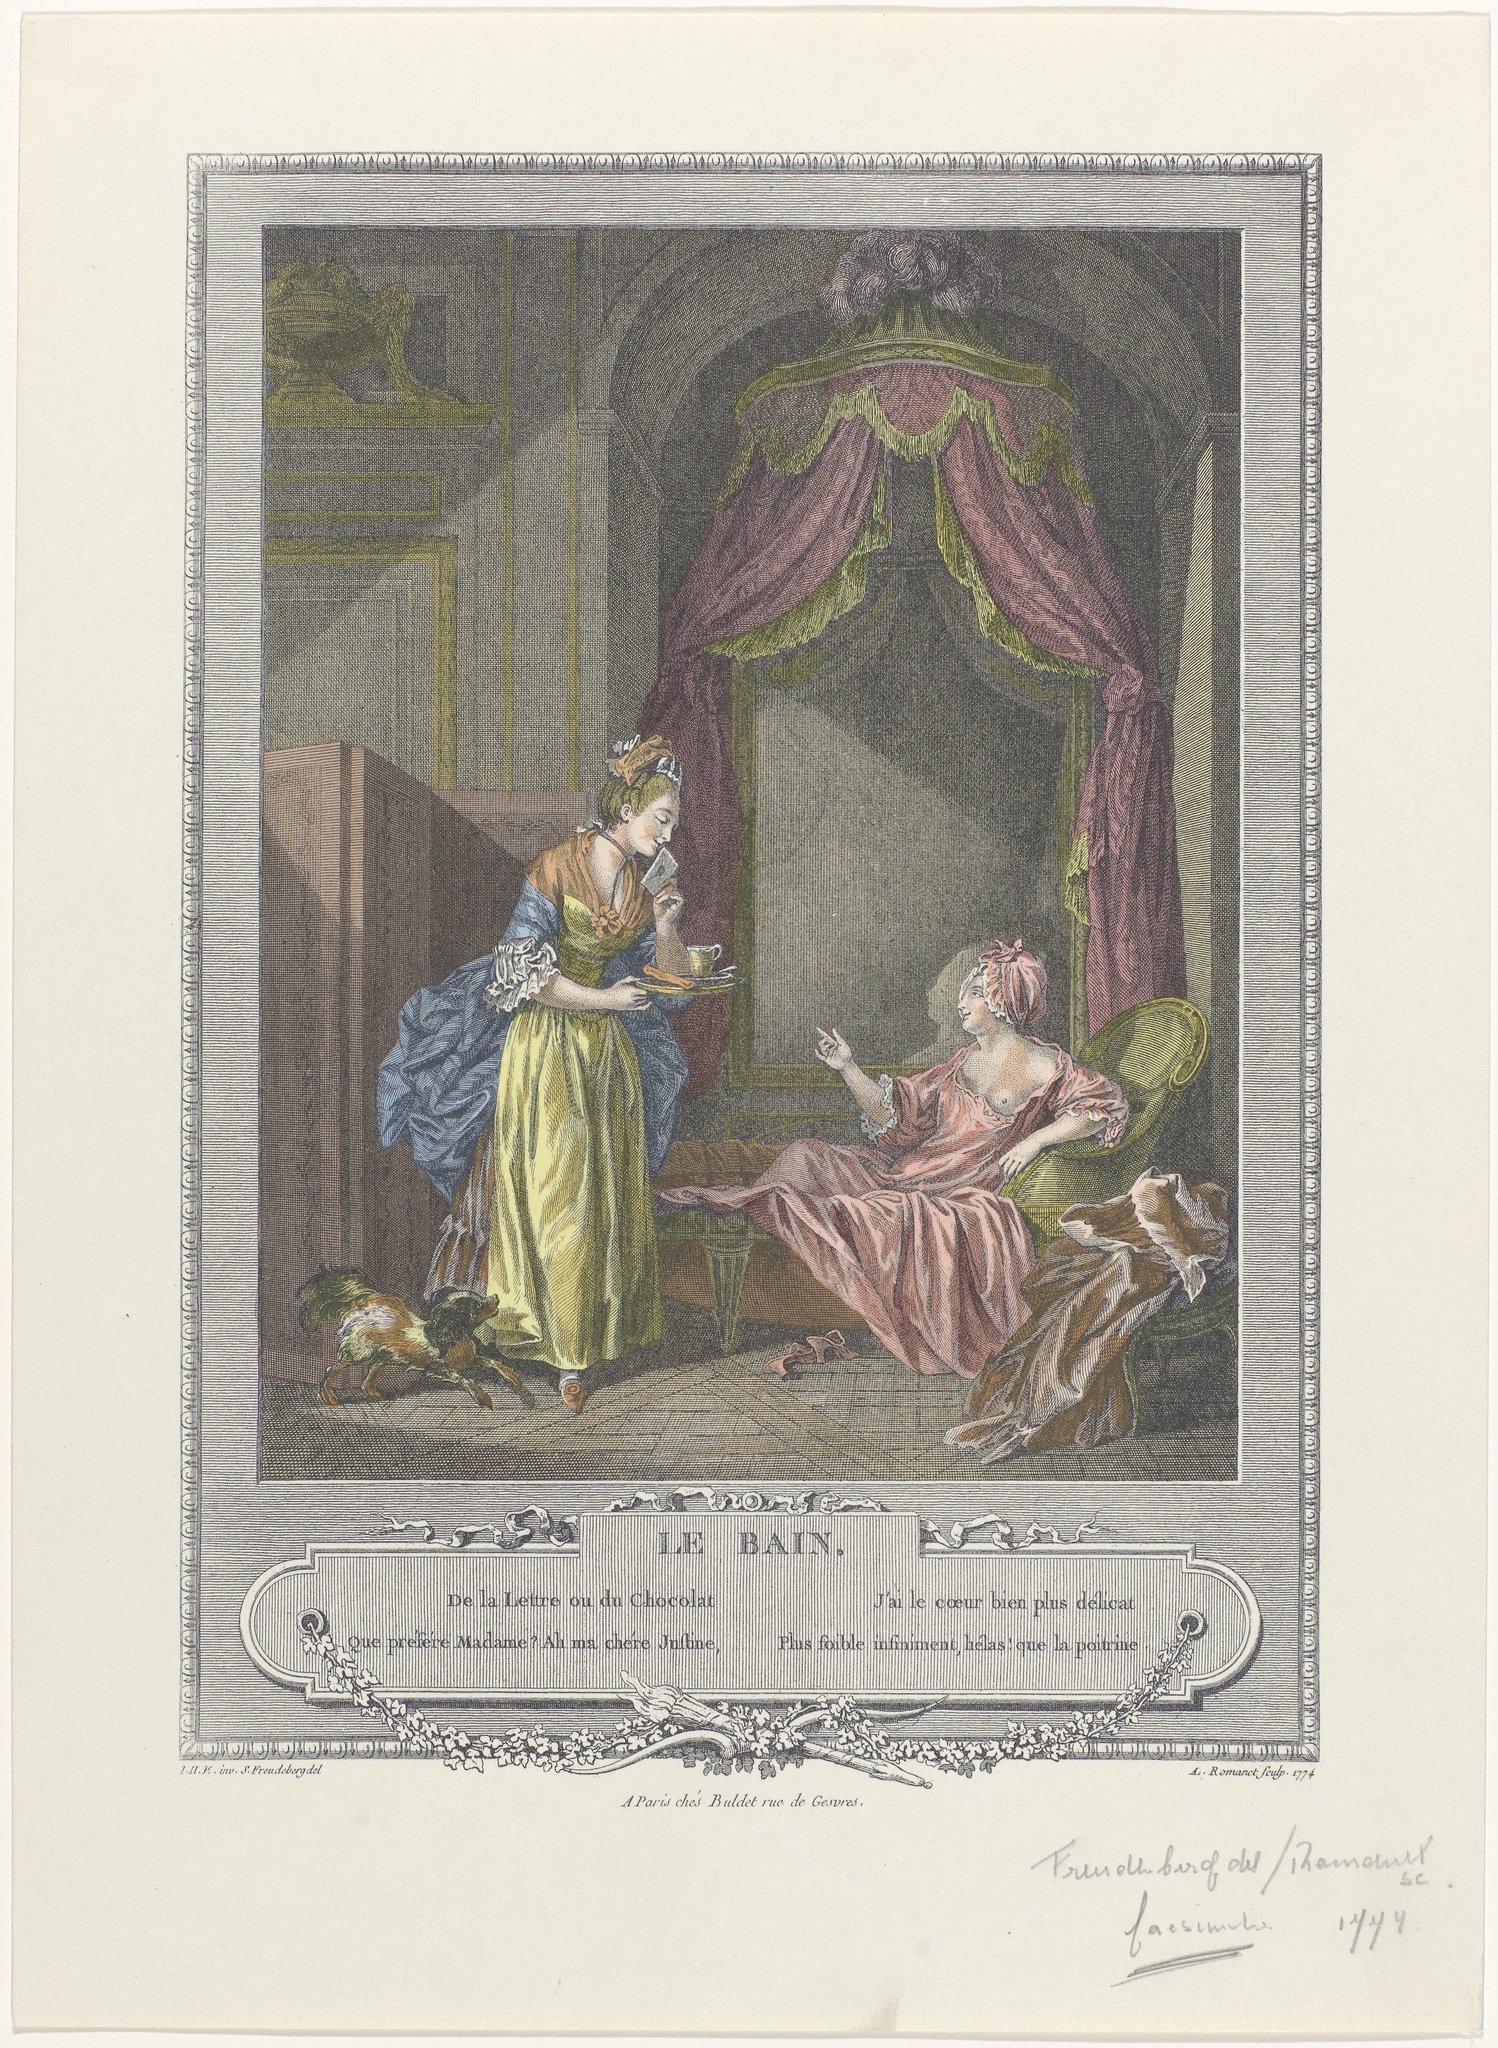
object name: print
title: Suite d'estampes pour servis à l 'histoire des moeurs et du costume Français dans le 18e Siecle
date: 1774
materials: paper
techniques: photochemical processes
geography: paris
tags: taking a bath, chocolate, cocoa, head-gear: cap (+ women's clothes), fashion plates, shoes, sandals (+ women's clothes), skirt (+ women's clothes), dress, gown (+ women's clothes), letter, envelope, maid ~ house personnel, apron (+ women's clothes), piece of clothing covering the breast or décolleté (fichu) (+ women's clothes), dog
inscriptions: title: ‘Le Bain.’, caption: ‘De la Lettre ou du Chocolat / Que préfére Madame? Ah ma chére Justine, / J'ai le coeur bien plus délicat / Plus foible infmiment, hélas: que la poitrine’, address: ‘A Paris chés Buldet rue de Gesvres.’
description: Bediende brengt een brief en een kop chocolade aan haar meesteres in de badkamer. Zij draagt een gestreepte japon, die achter is opgehouden. Over het lijf en de rok is een schort gespeld. Om de hals en schouders een fichu. Accessoires: muts, koord om de hals, schoenen met gespen. De vrouw in bad is gehuld in een wijd kleed, op het hoofd een muts. Naast het bad muiltjes met hakken. De prent is een nauwkeurige reproductie of facsimile van nummer 2 uit de Suite d'estampes pour servis à l 'histoire des moeurs et du costume Français dans le 18e Siecle, getekend door Sigismond Freudeberg, 1774.